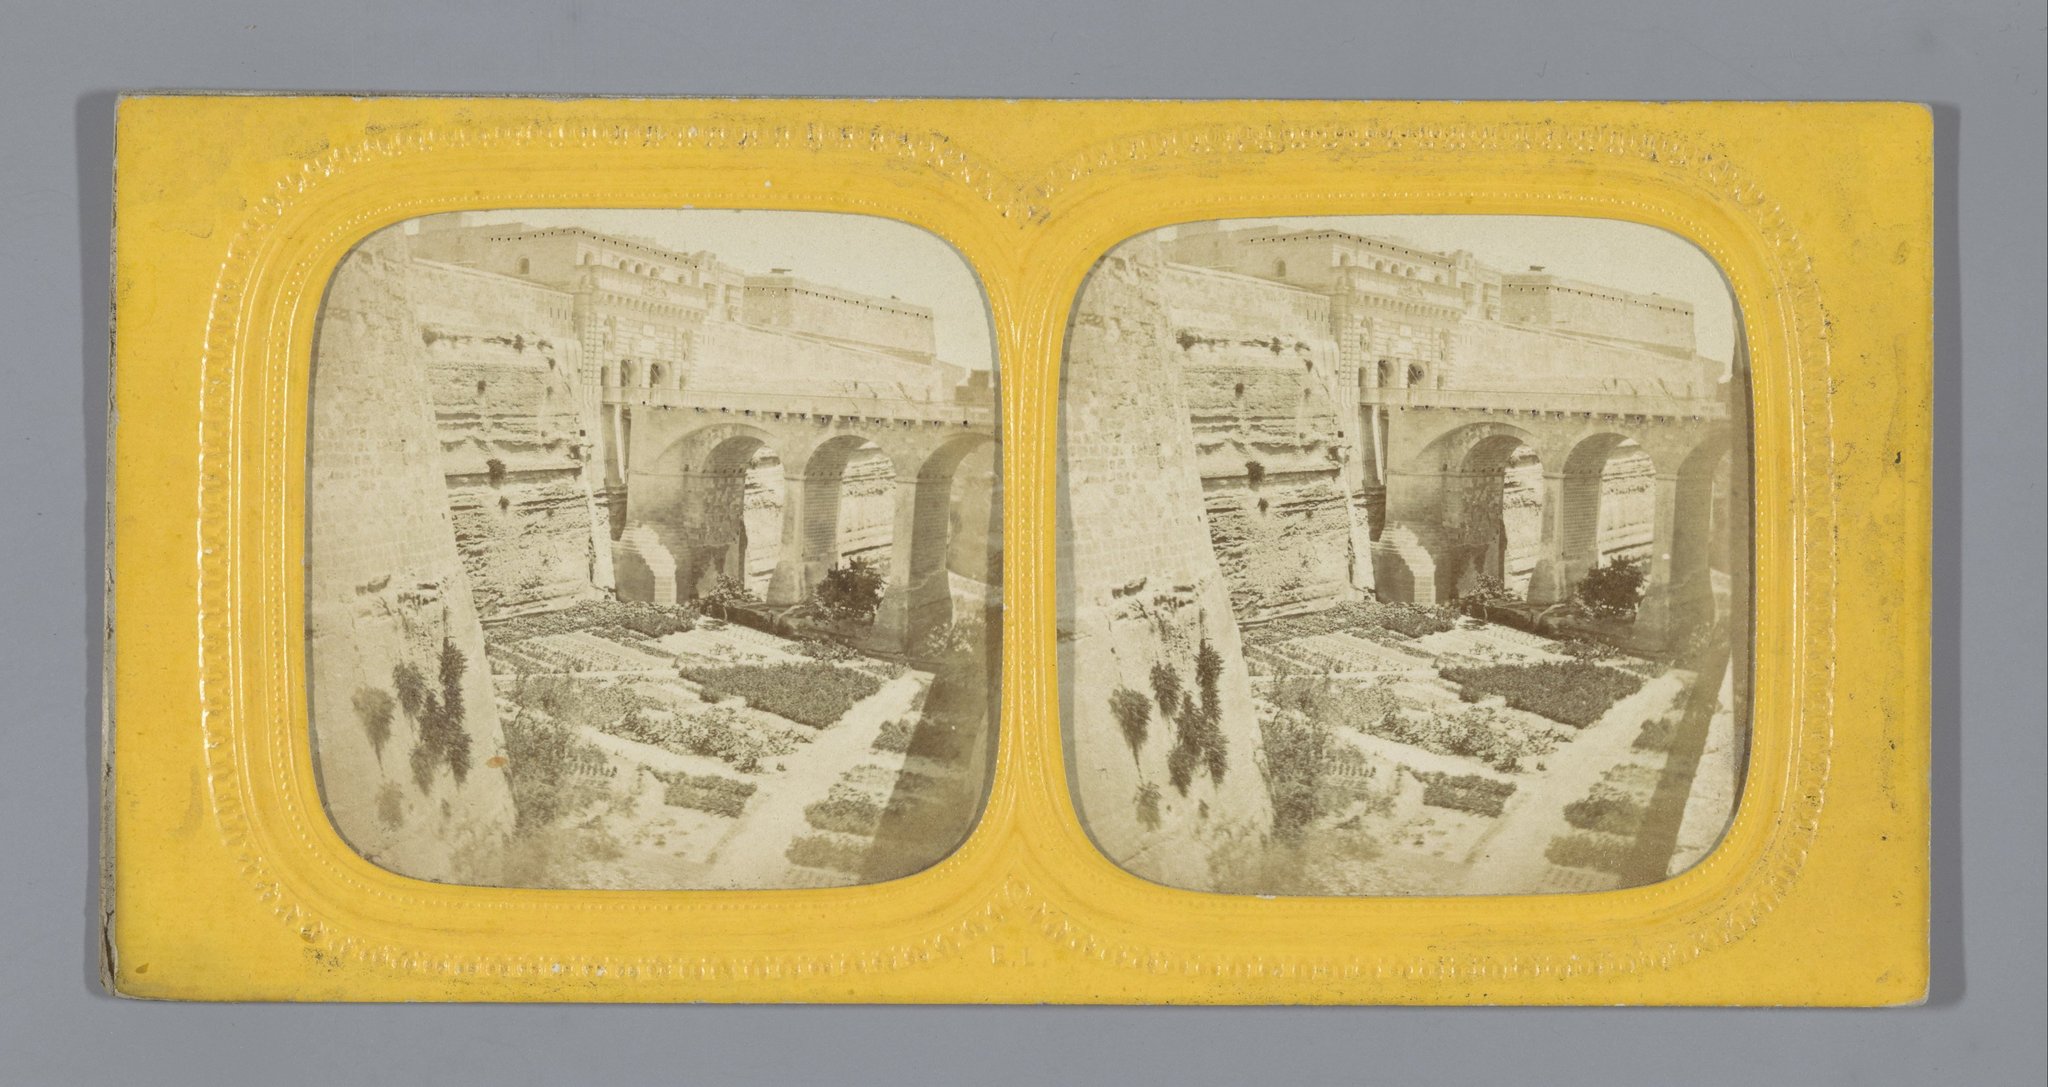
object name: tissue stereograph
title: Veduta di Porta Reale-Malta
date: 1855-1875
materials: cardboard, paper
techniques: albumen print, hand coloring, perforating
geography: paris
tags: walls ~ fortified city, city-gate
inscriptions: number: ‘16’